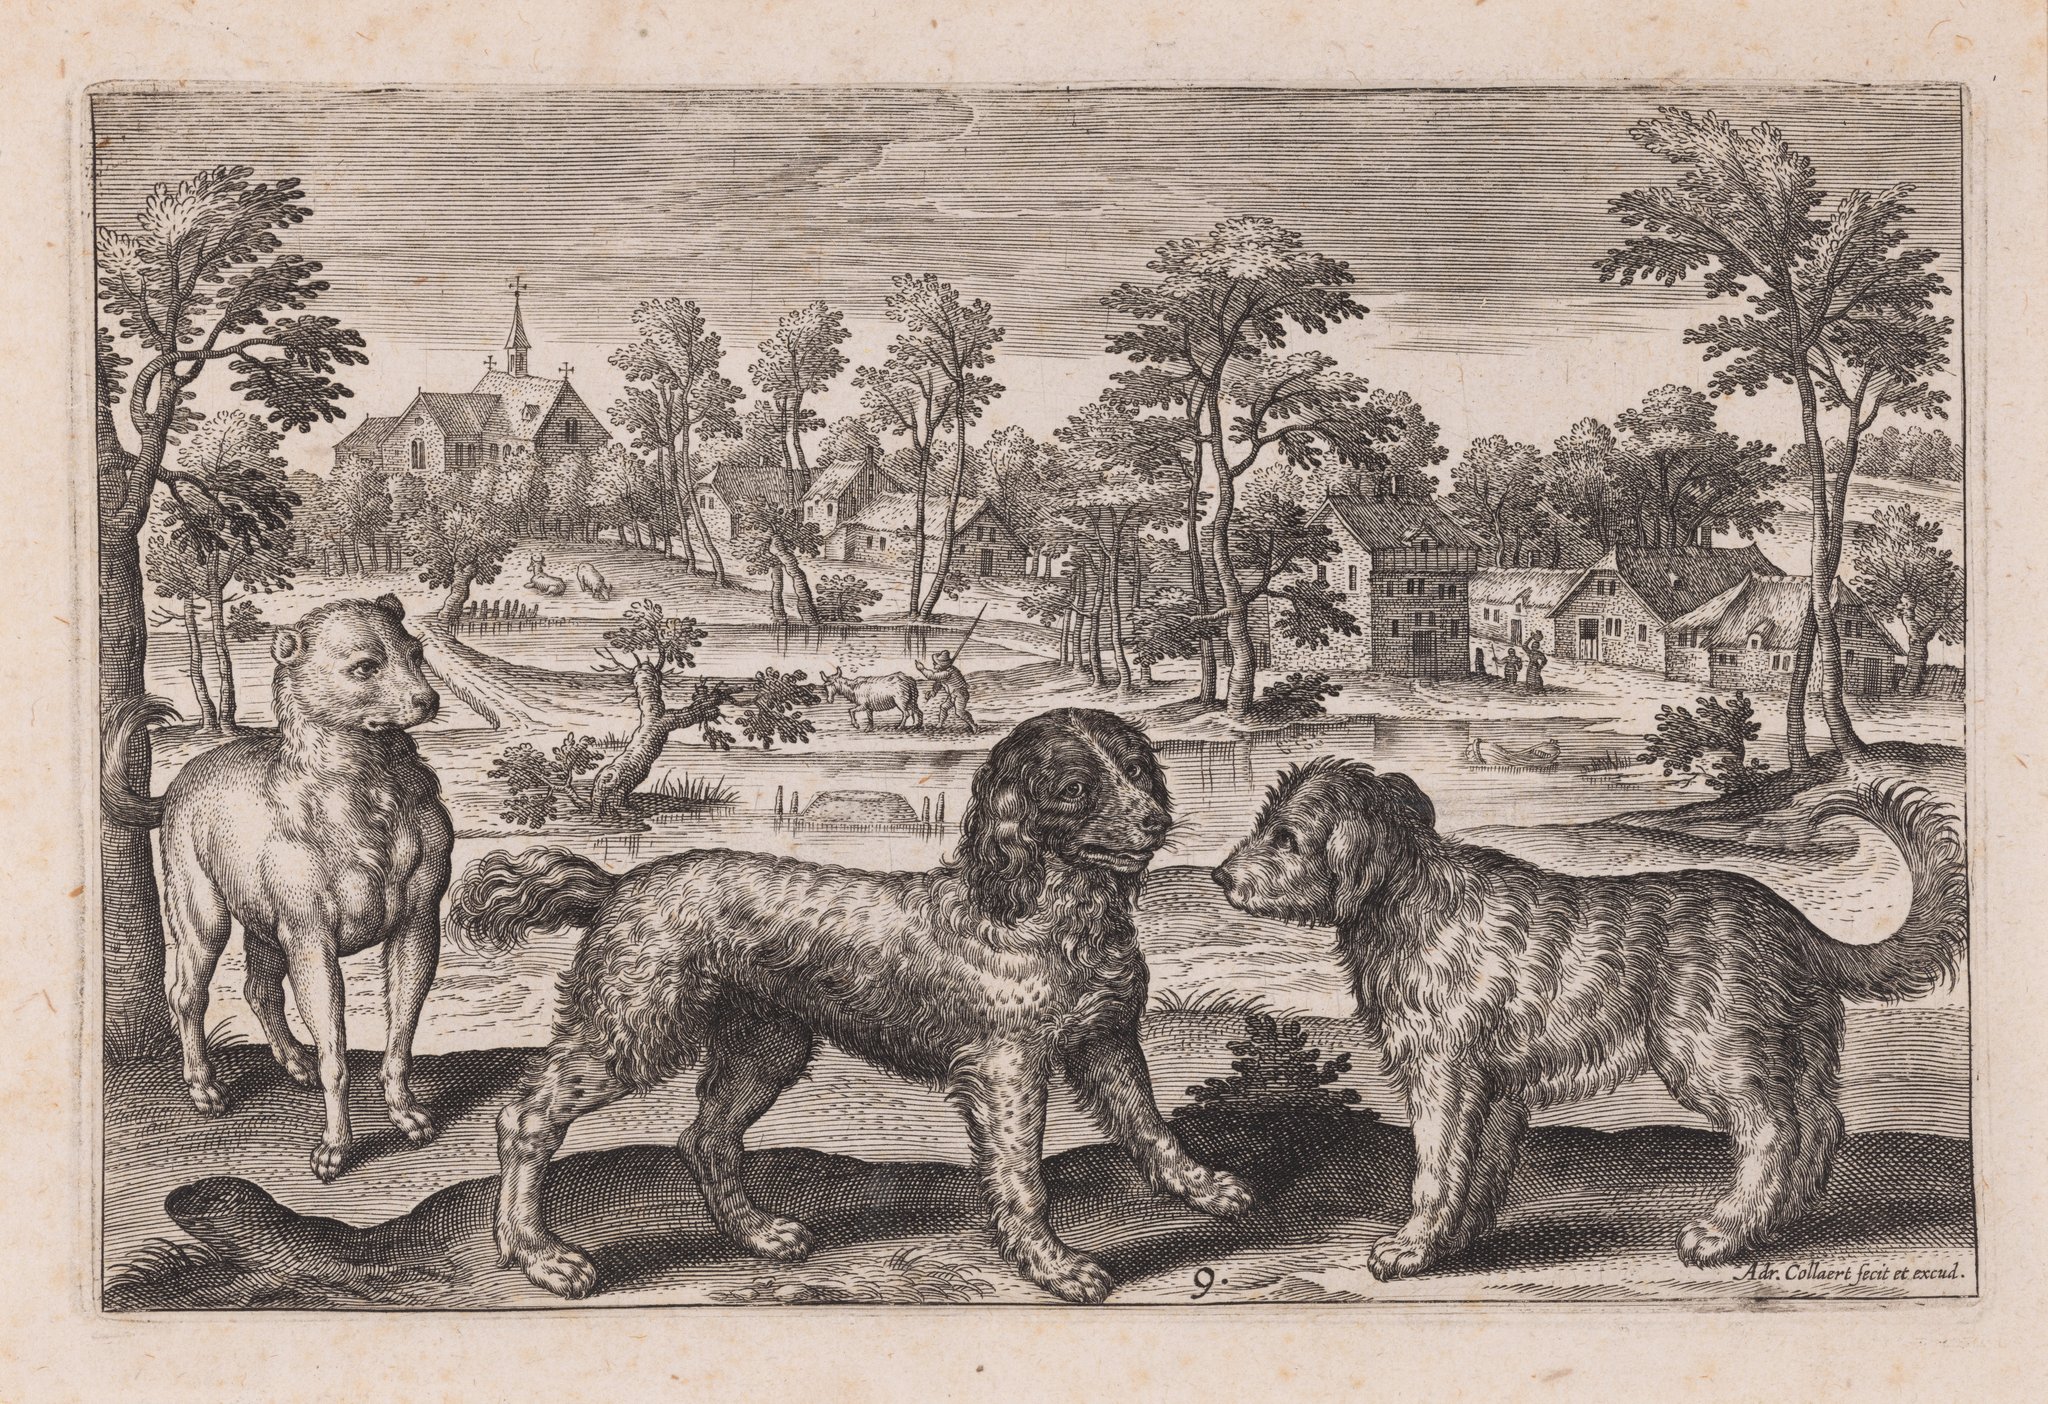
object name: print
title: Three Dogs, plate 9 from a set of Four Legged Animals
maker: adriaen collaert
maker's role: artist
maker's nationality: netherlandish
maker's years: 1560-1618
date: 1597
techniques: engraving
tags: dogs